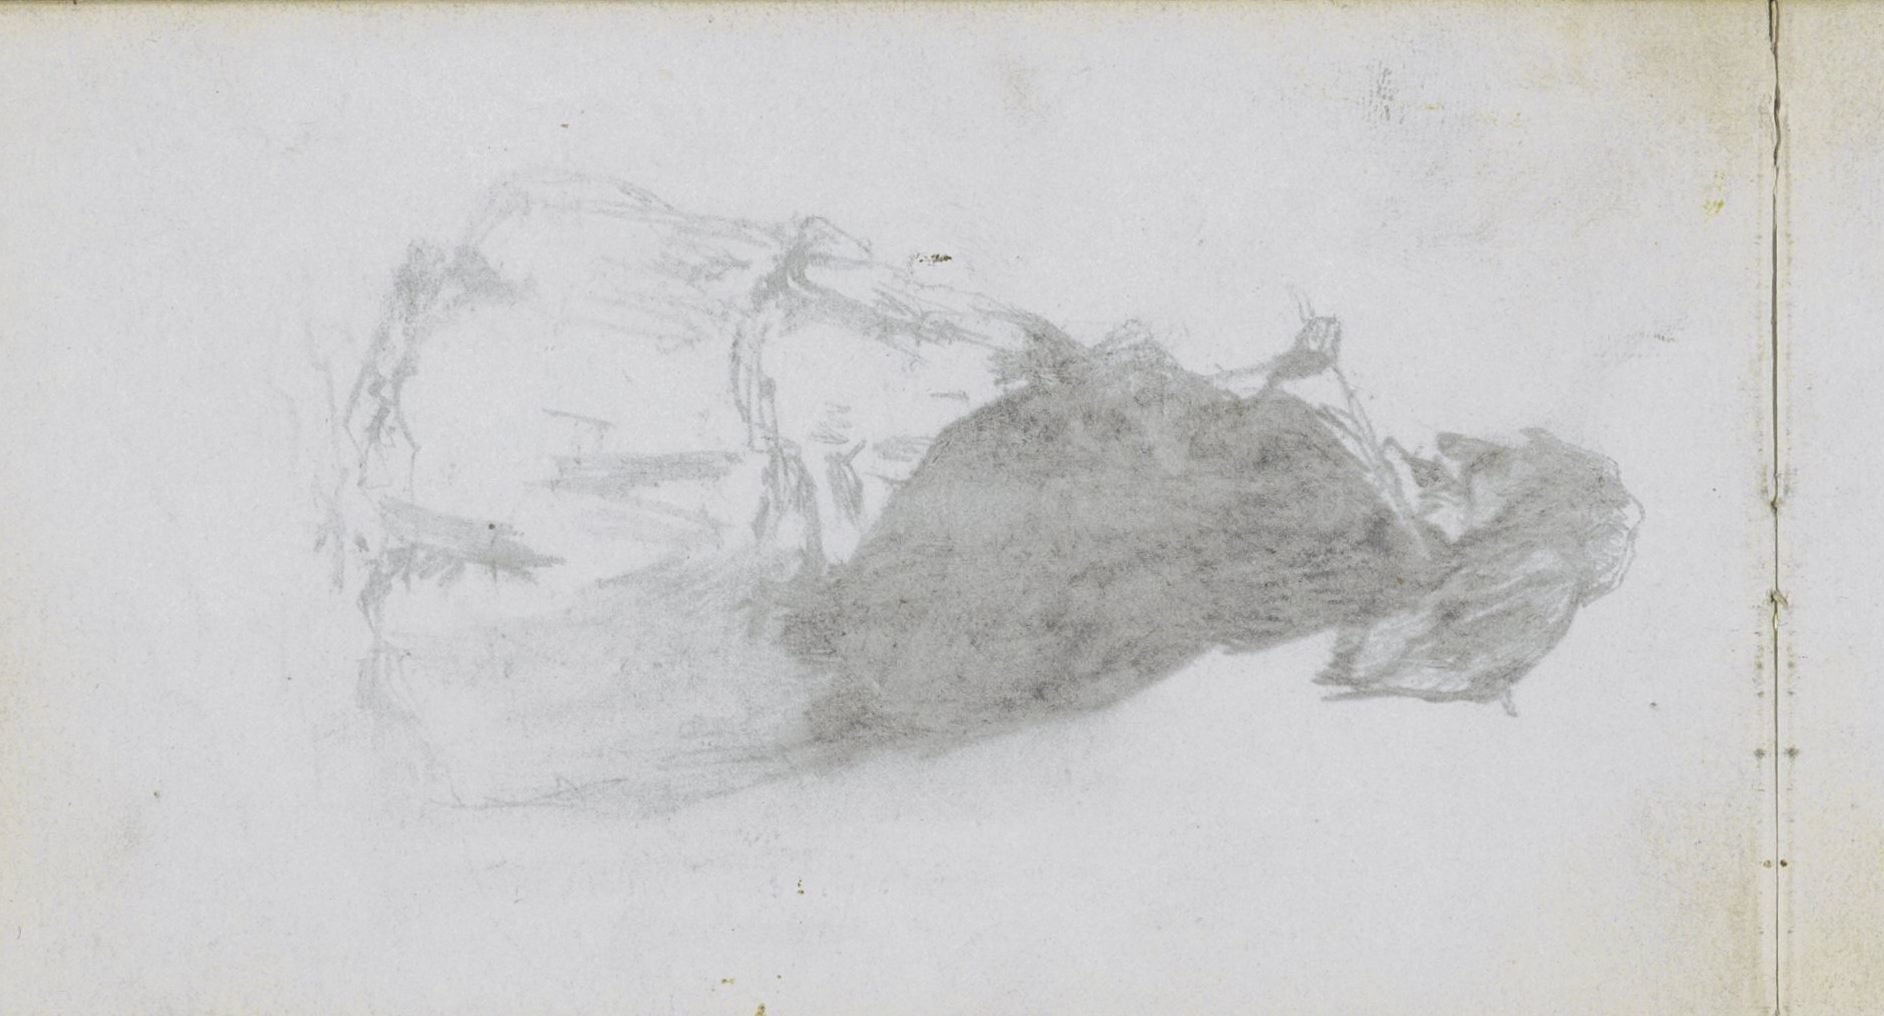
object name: sketchbook leaf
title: Abklatsch van de tekening op pagina 10 recto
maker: johan hendrik weissenbruch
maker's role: draughtsman, painter, print maker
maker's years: 1824-1903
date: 1834-1903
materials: paper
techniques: printmaking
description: Blad 9 verso uit een schetsboek met 39 bladen.